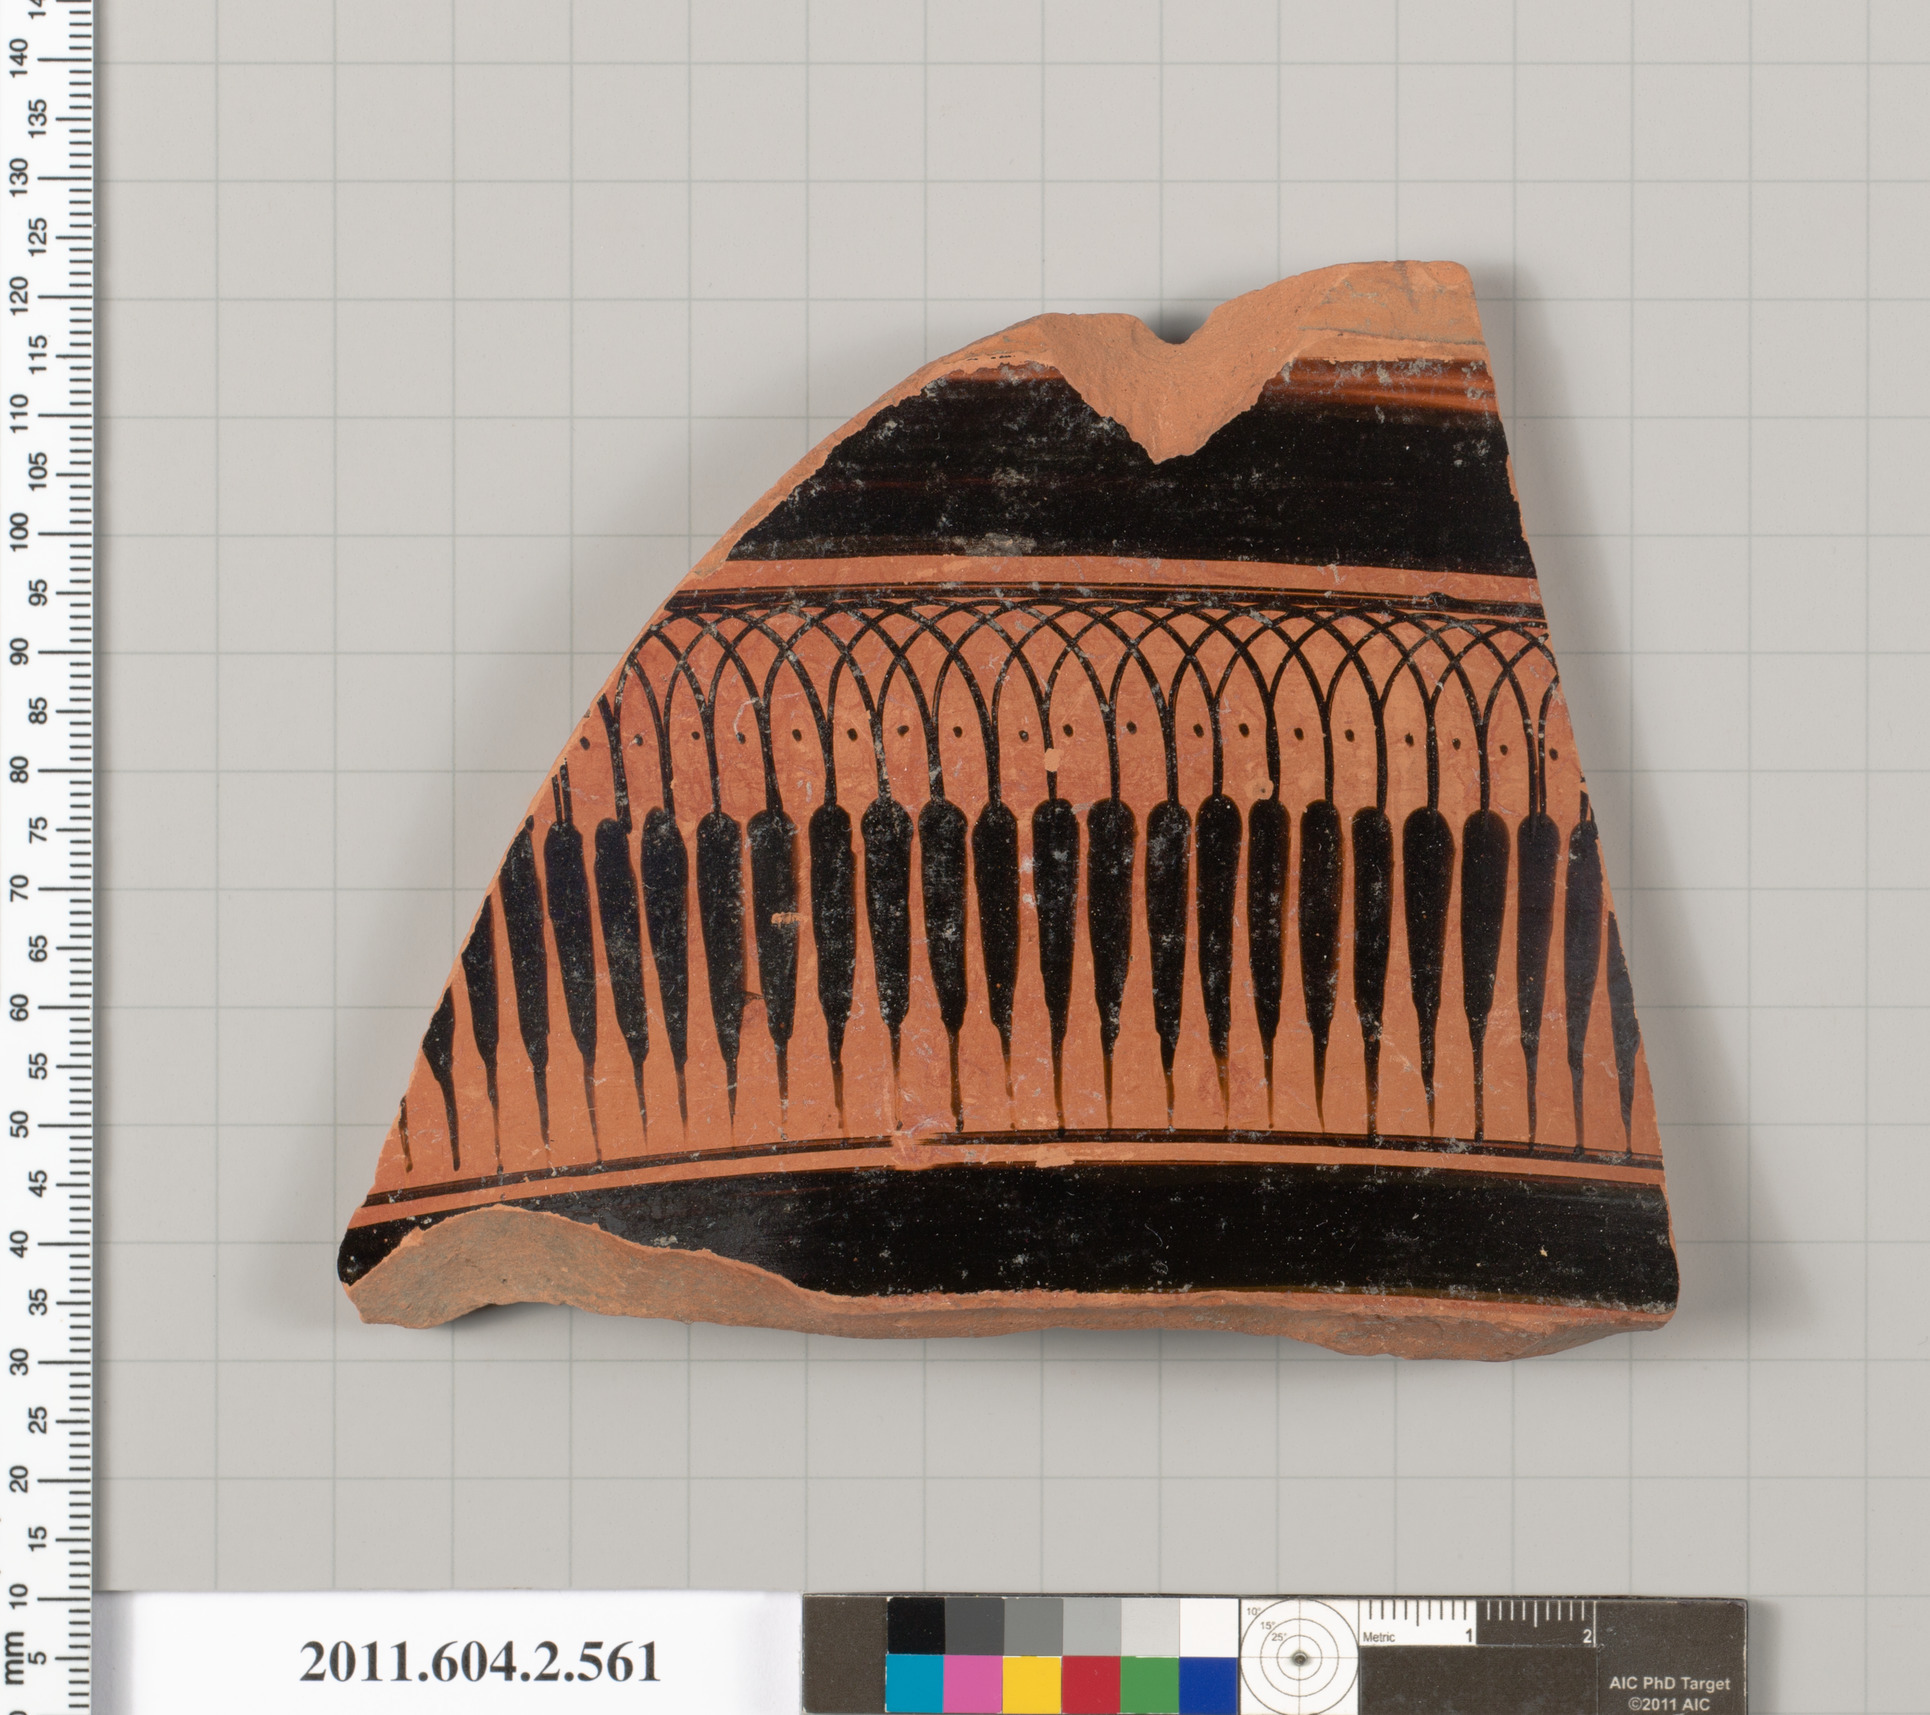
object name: column krater fragment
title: Terracotta fragment of a column-krater (bowl for mixing wine and water)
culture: greek, attic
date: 470-450 BCE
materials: terracotta